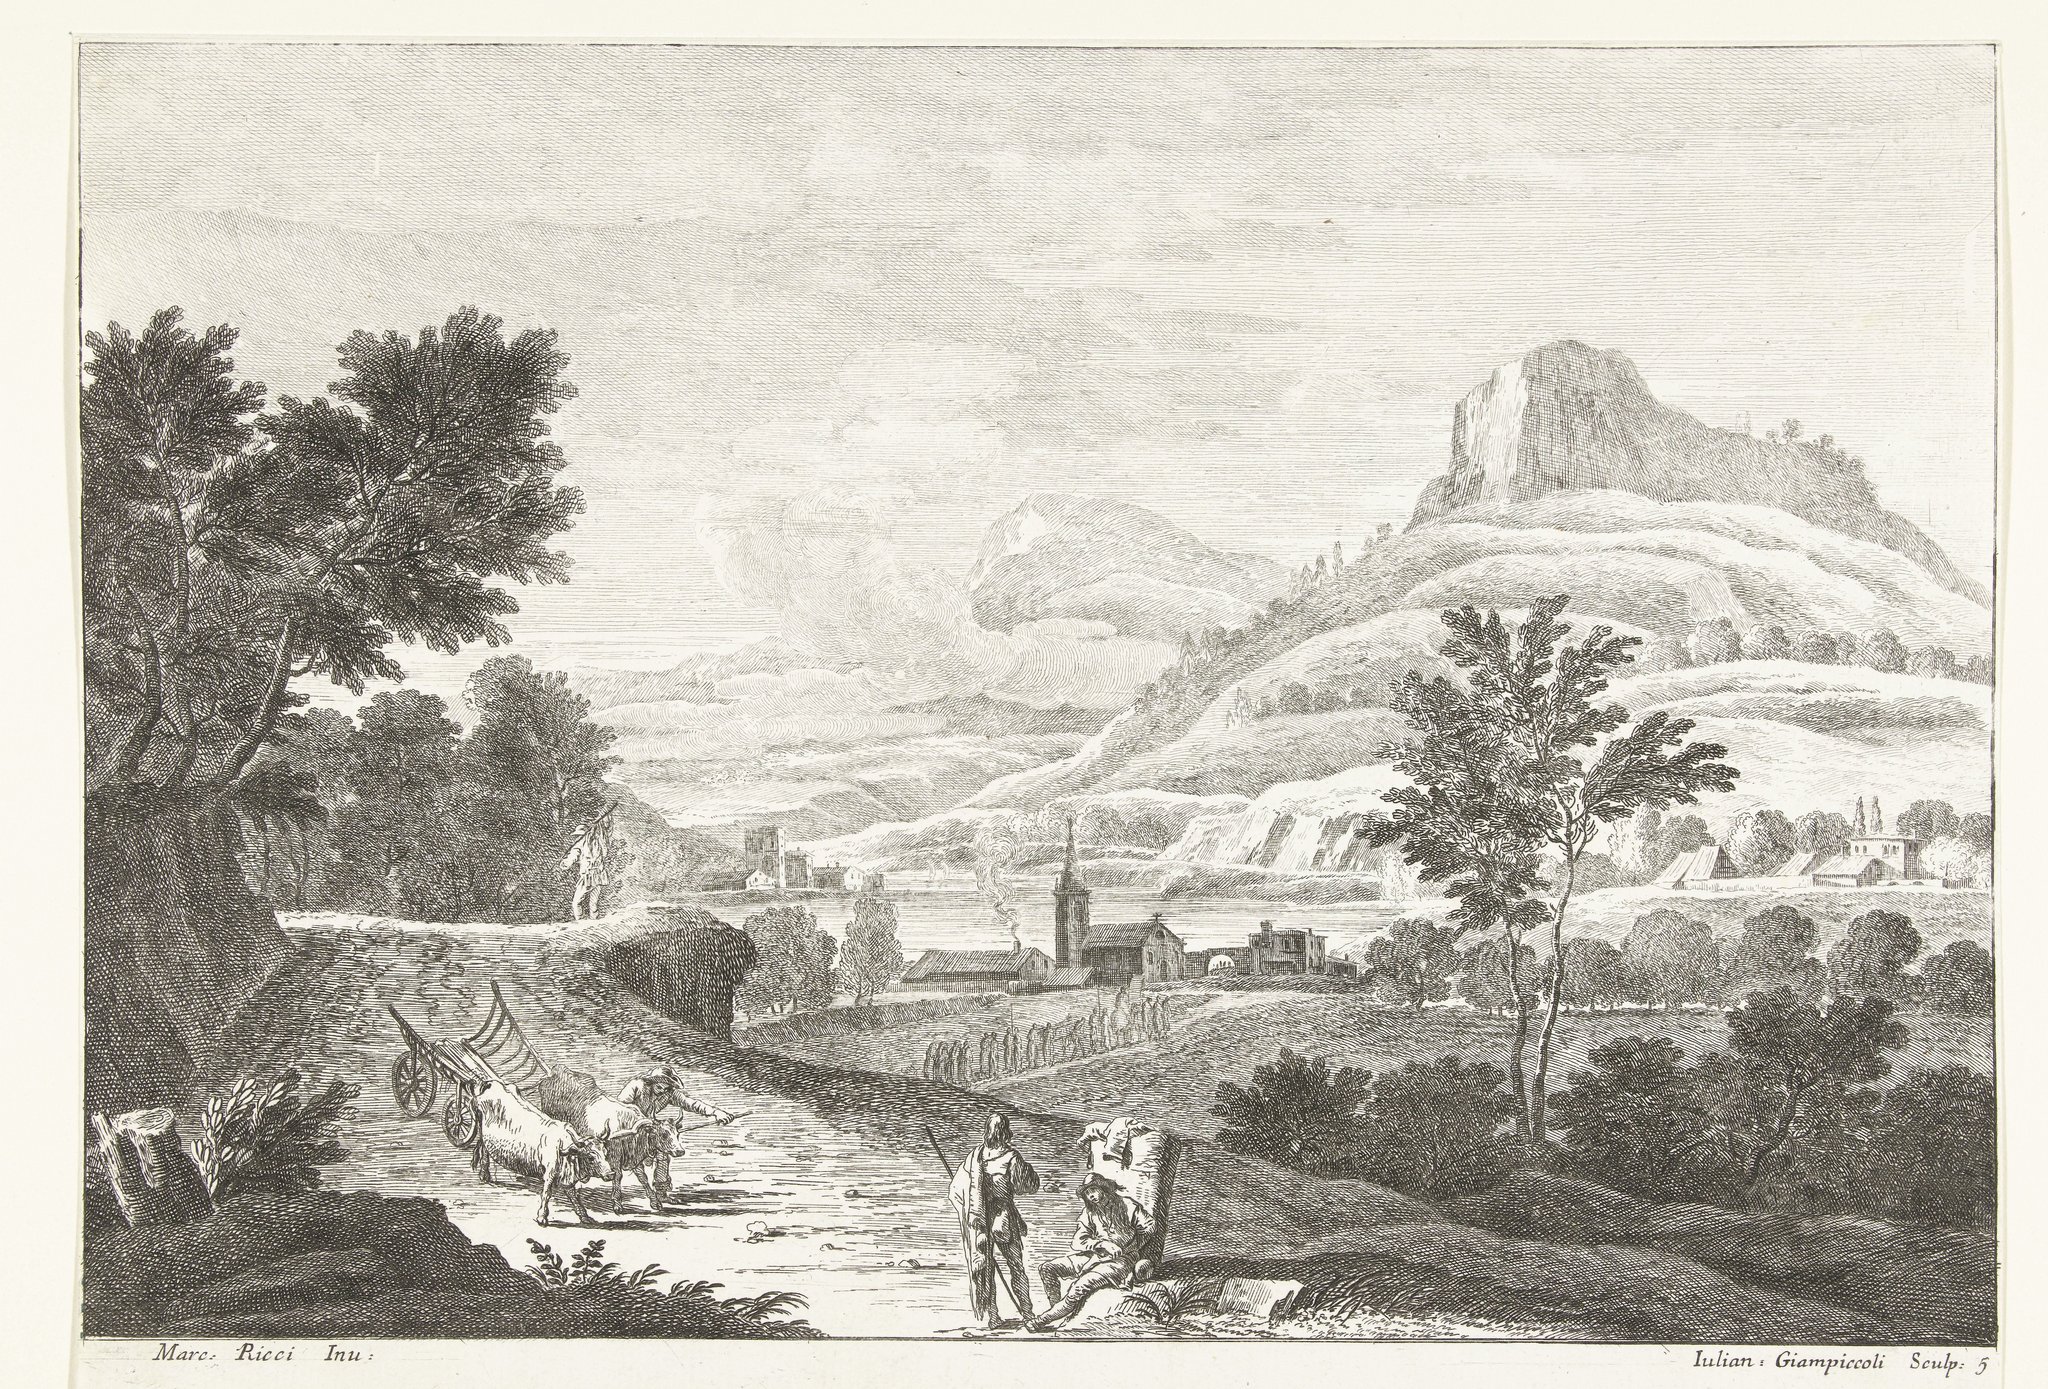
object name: print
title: Italiaanse landschappen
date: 1739-1740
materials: paper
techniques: etching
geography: venice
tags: funerary ceremonial, mountains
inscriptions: collector's mark: Lugt 2228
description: Prent uit eerste serie van achttien prenten met Italiaanse landschappen naar ontwerp van Marco Ricci en titelprent (zie RP-P-1952-20) opgedragen aan consul Joseph Smith.